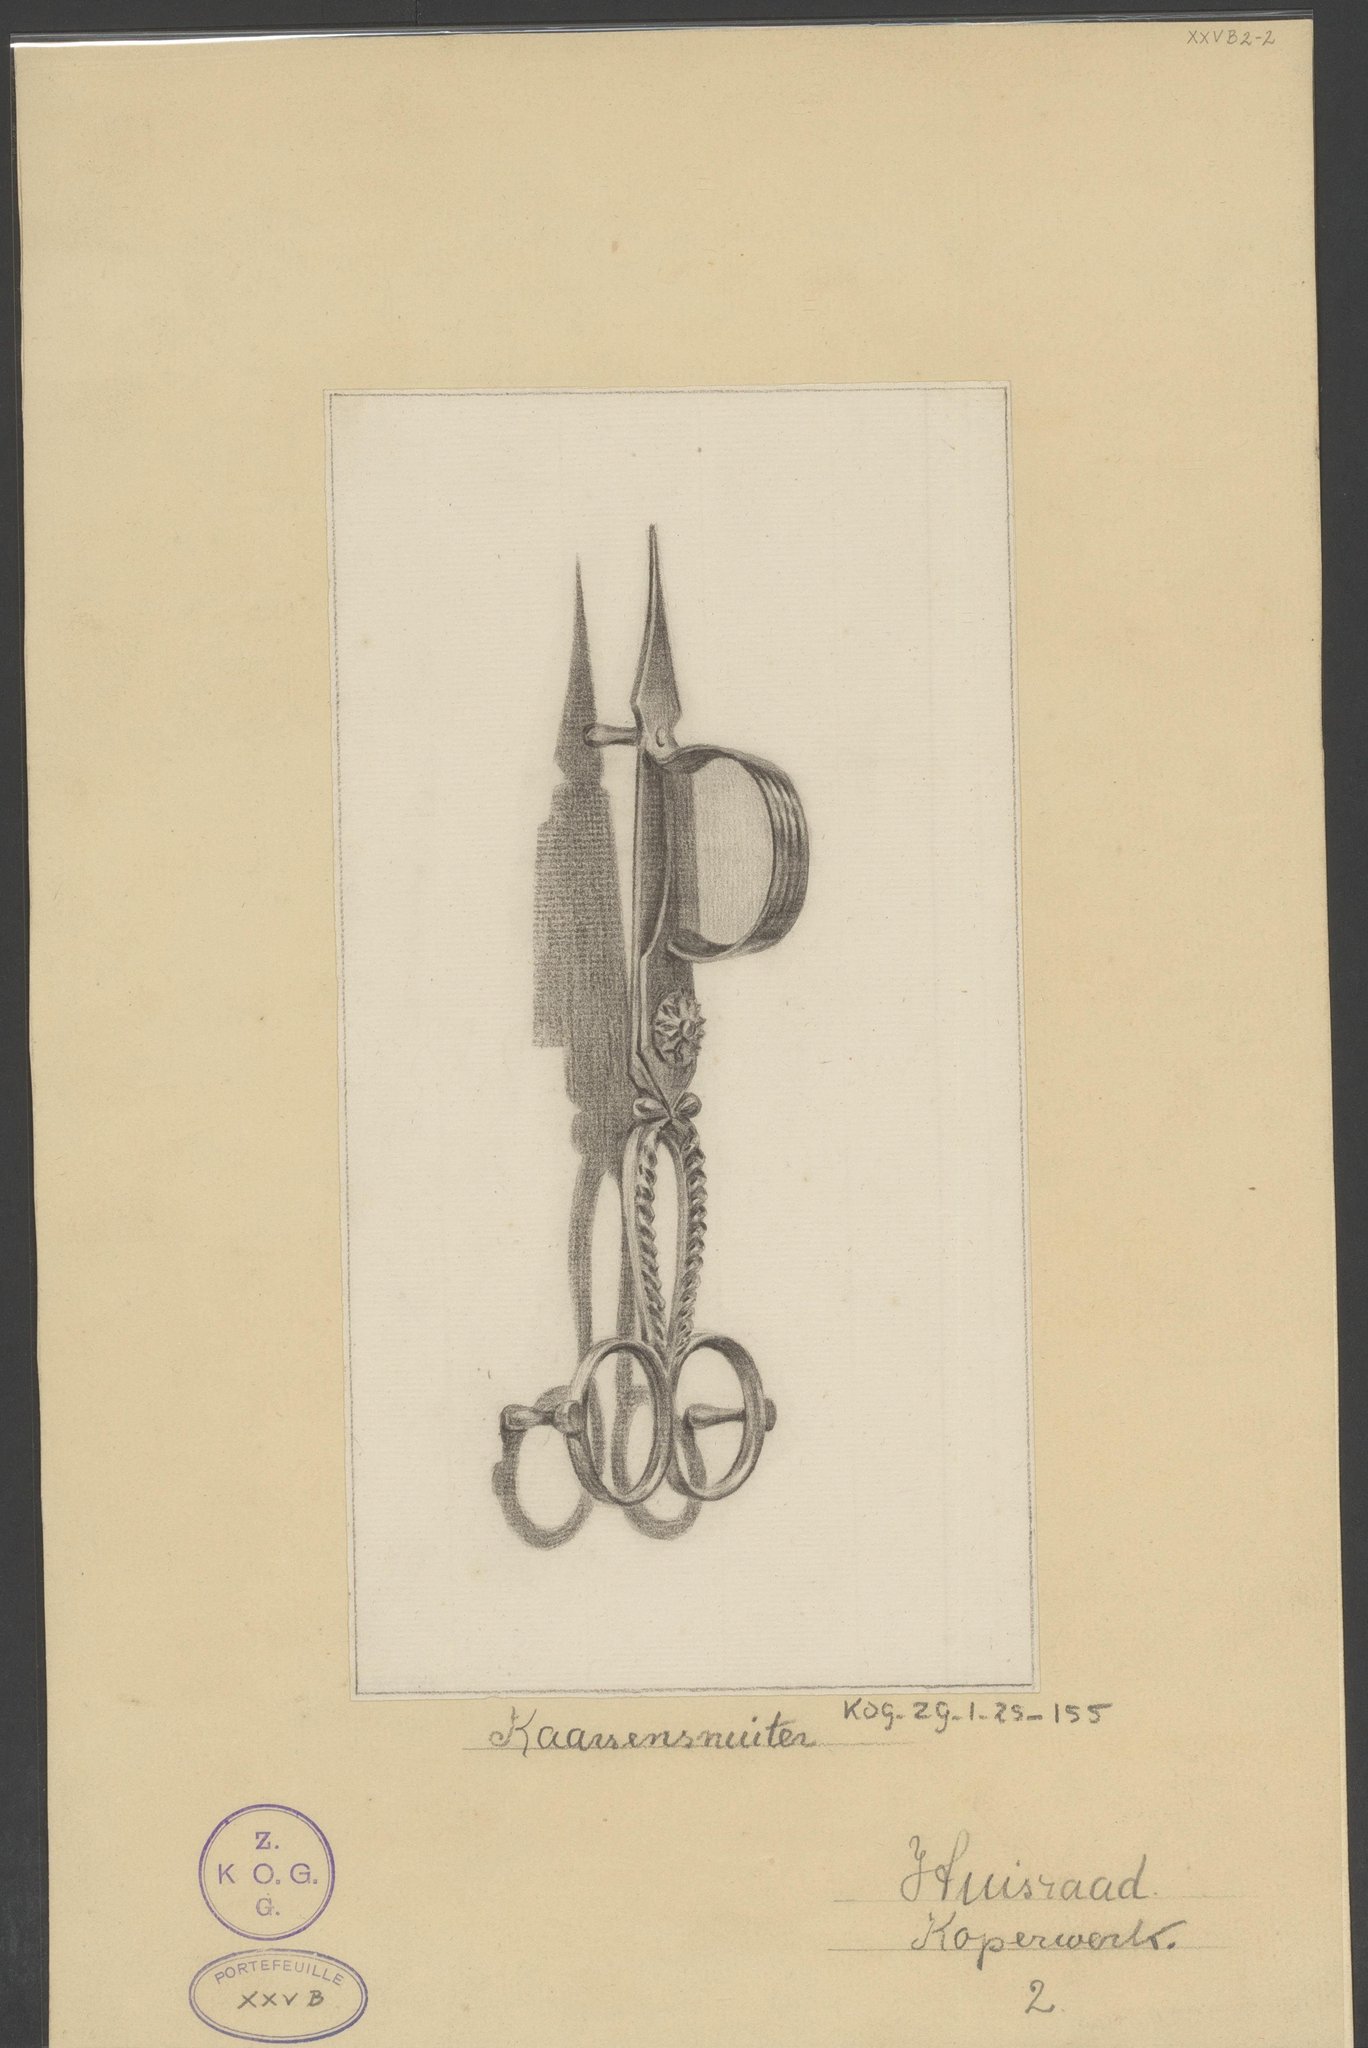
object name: drawing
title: Kaarsensnuiter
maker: Anonymous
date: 1750-1849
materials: chalk, paper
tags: snuffers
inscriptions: collector's mark: Lugt 1641, stamp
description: Onderwerpsrubrieken binnen de Atlas Zeden en Gewoonten: Zeden en Gewoonten in Engeren Zin, De Woning, Huisraad, Koperwerk.